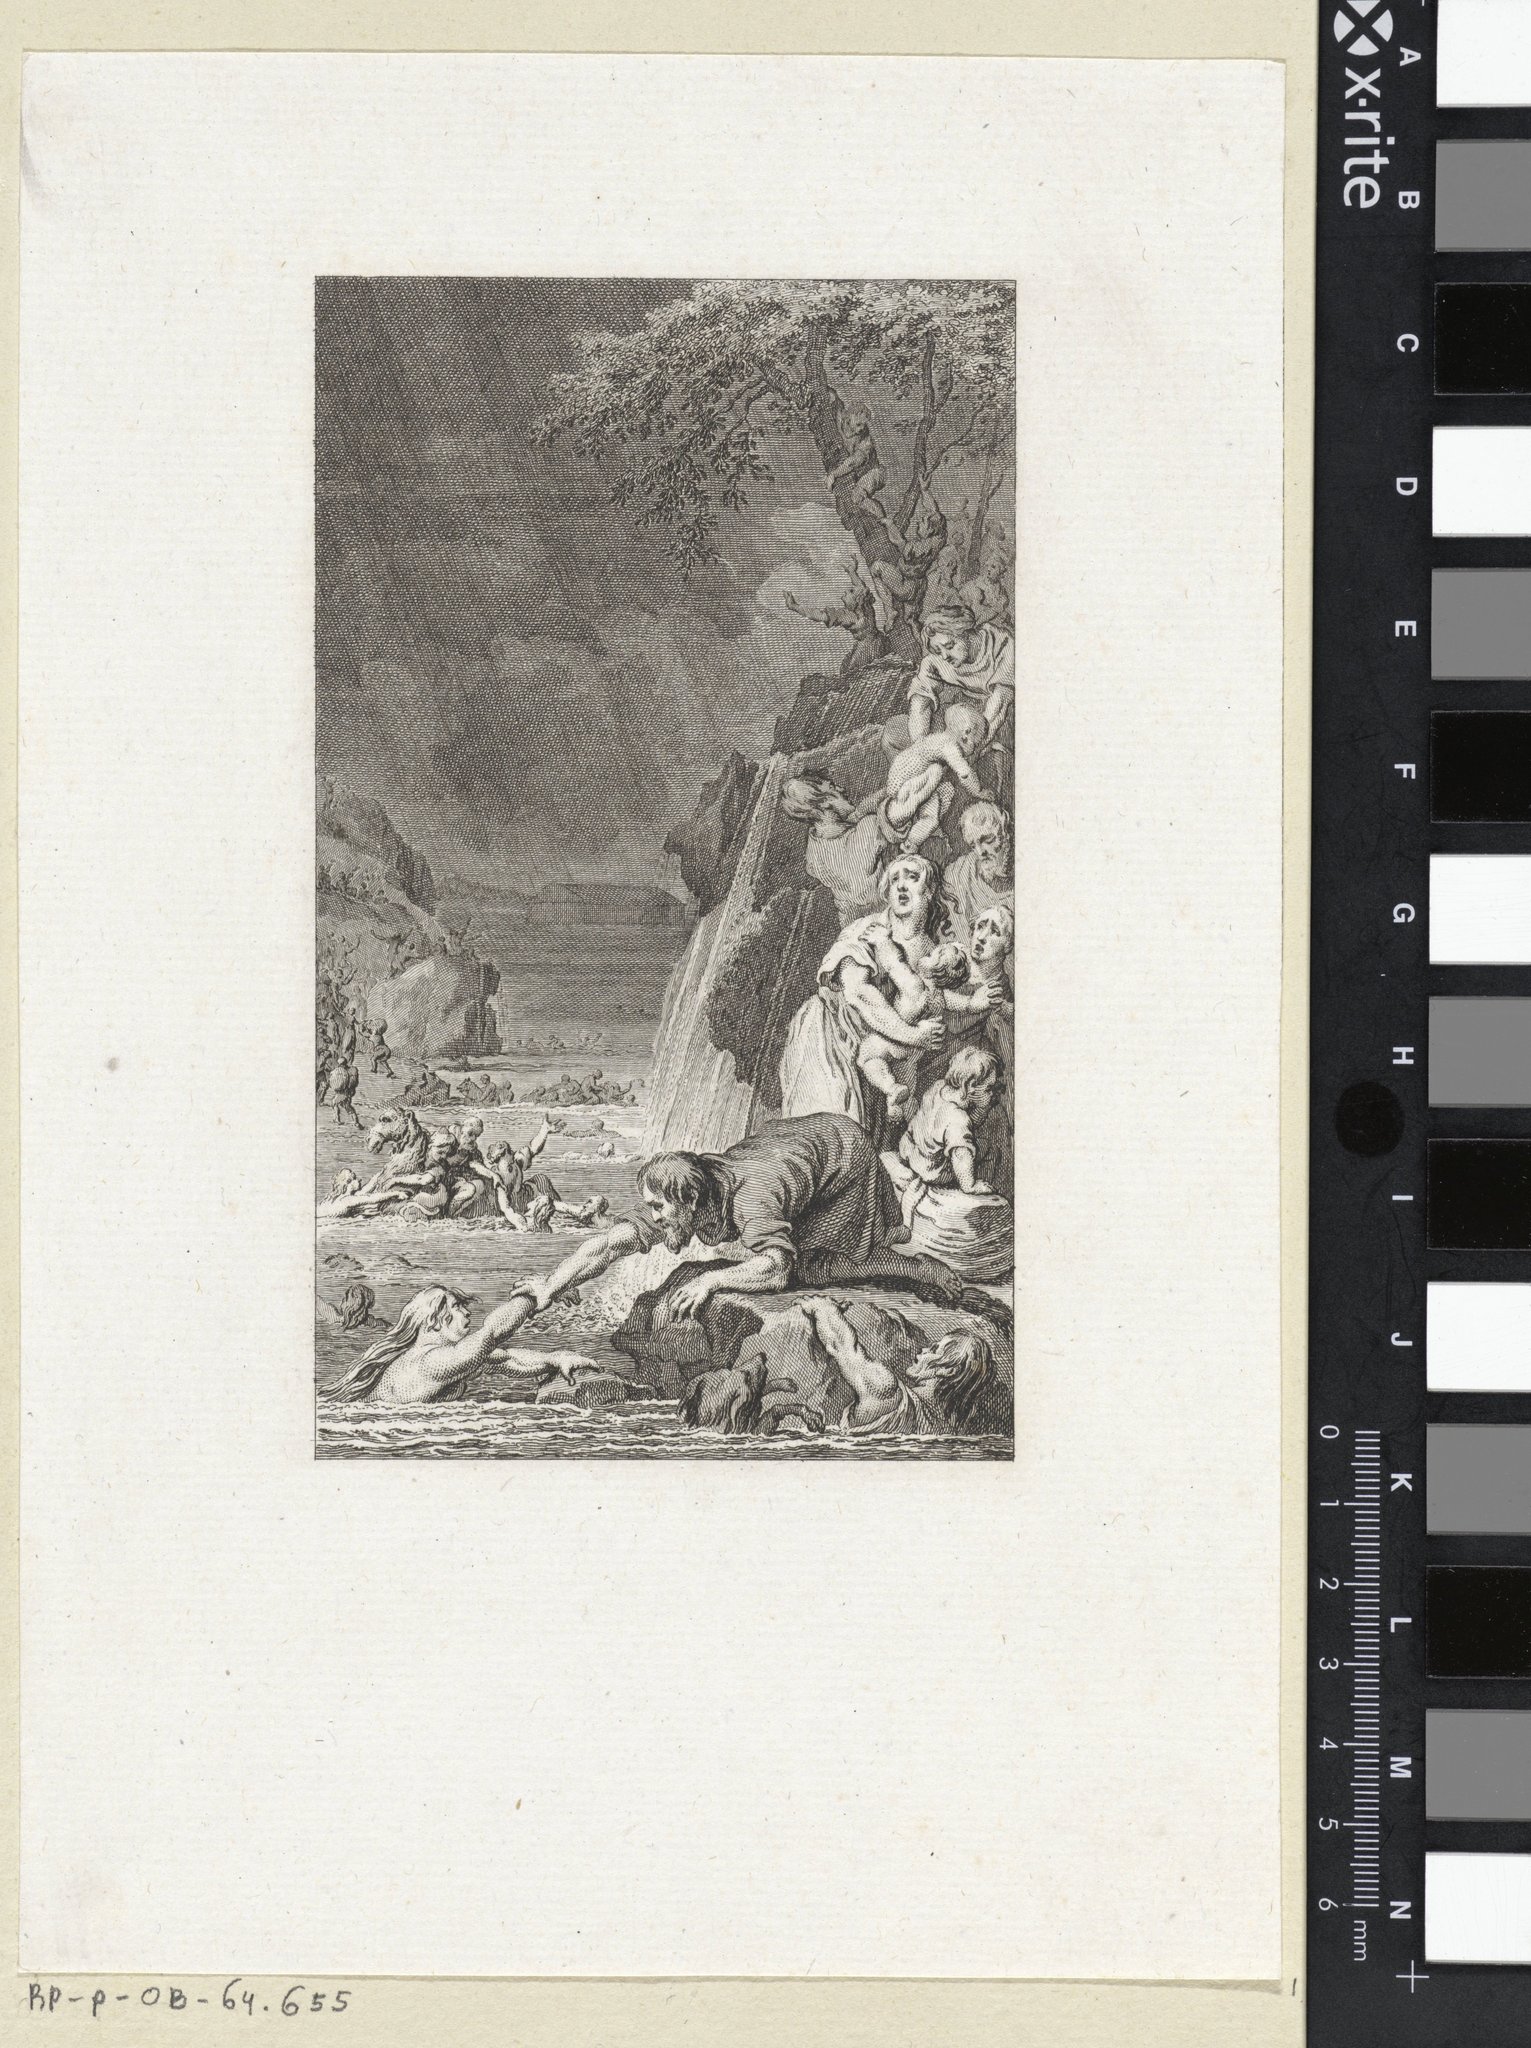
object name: print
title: Zondvloed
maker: reinier vinkeles (i)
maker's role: draughtsman, print maker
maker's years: 1741-1816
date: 1793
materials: paper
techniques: engraving, etching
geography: amsterdam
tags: the flood and destruction of mankind ~ story of noah (genesis 7:10 - 8:17)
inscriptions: collector's mark: Lugt 240